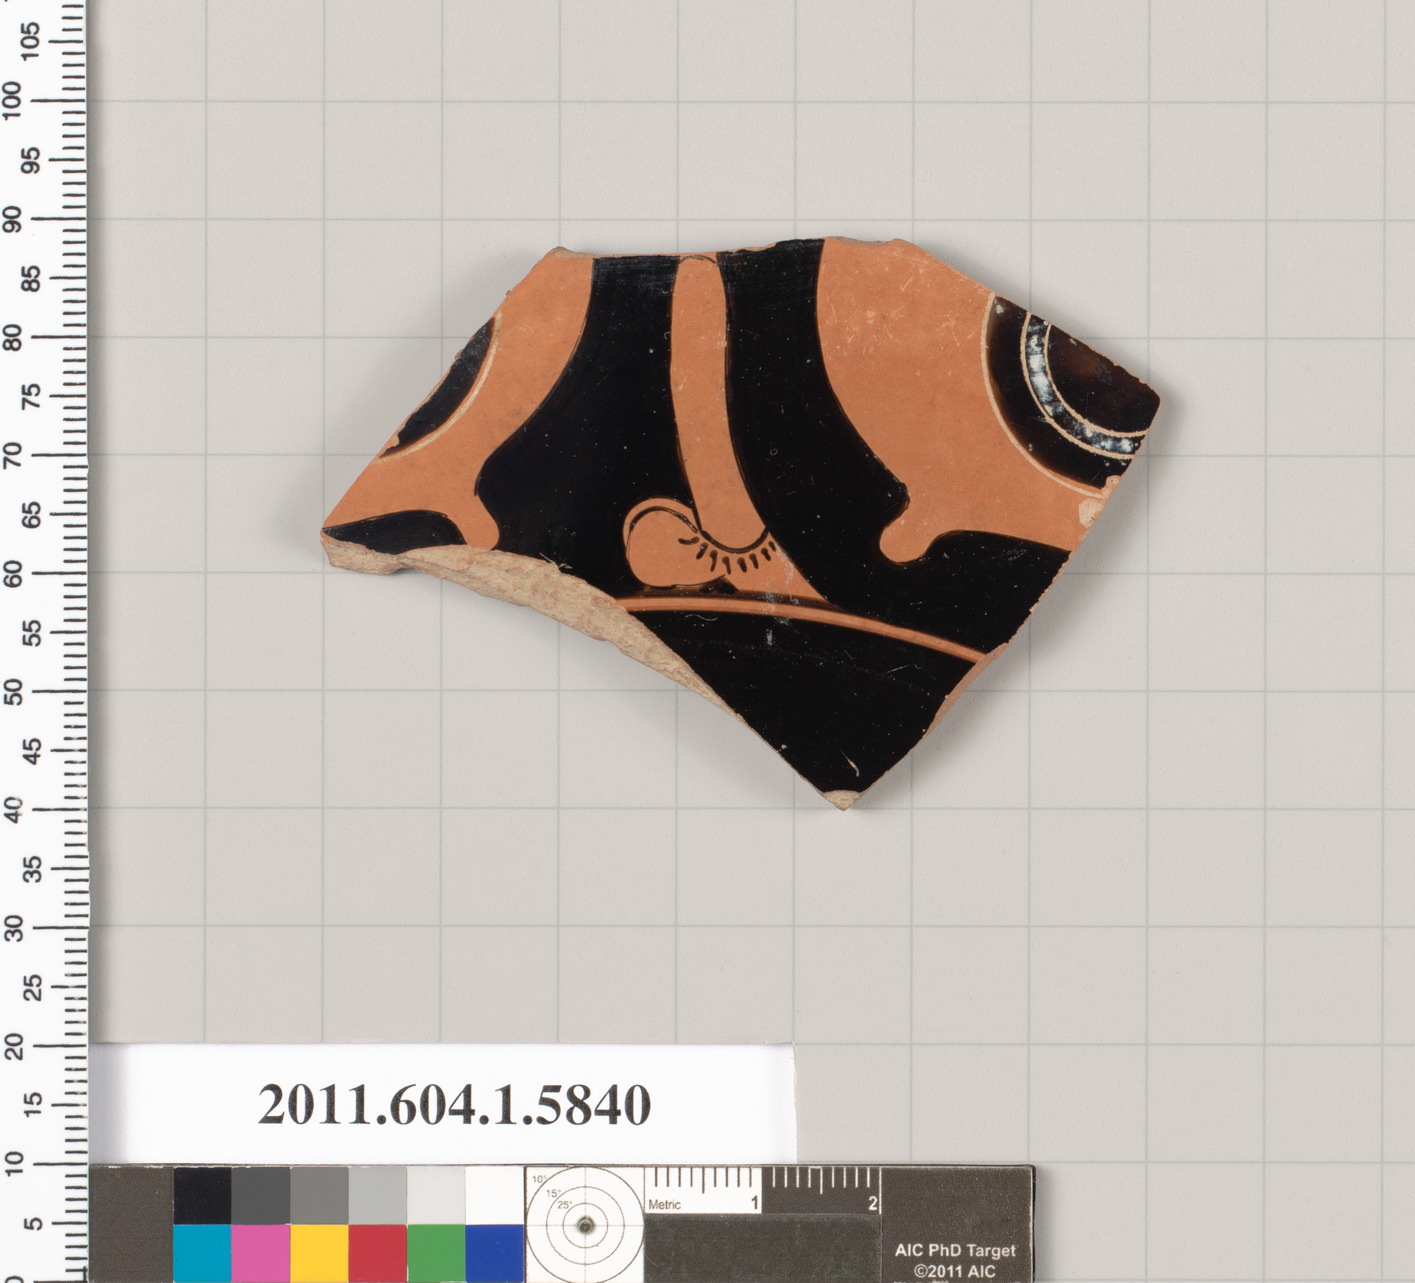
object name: kylix fragment, eye cup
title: Terracotta fragment of a kylix: eye-cup (drinking cup)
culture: greek, attic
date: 520-515 BCE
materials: terracotta